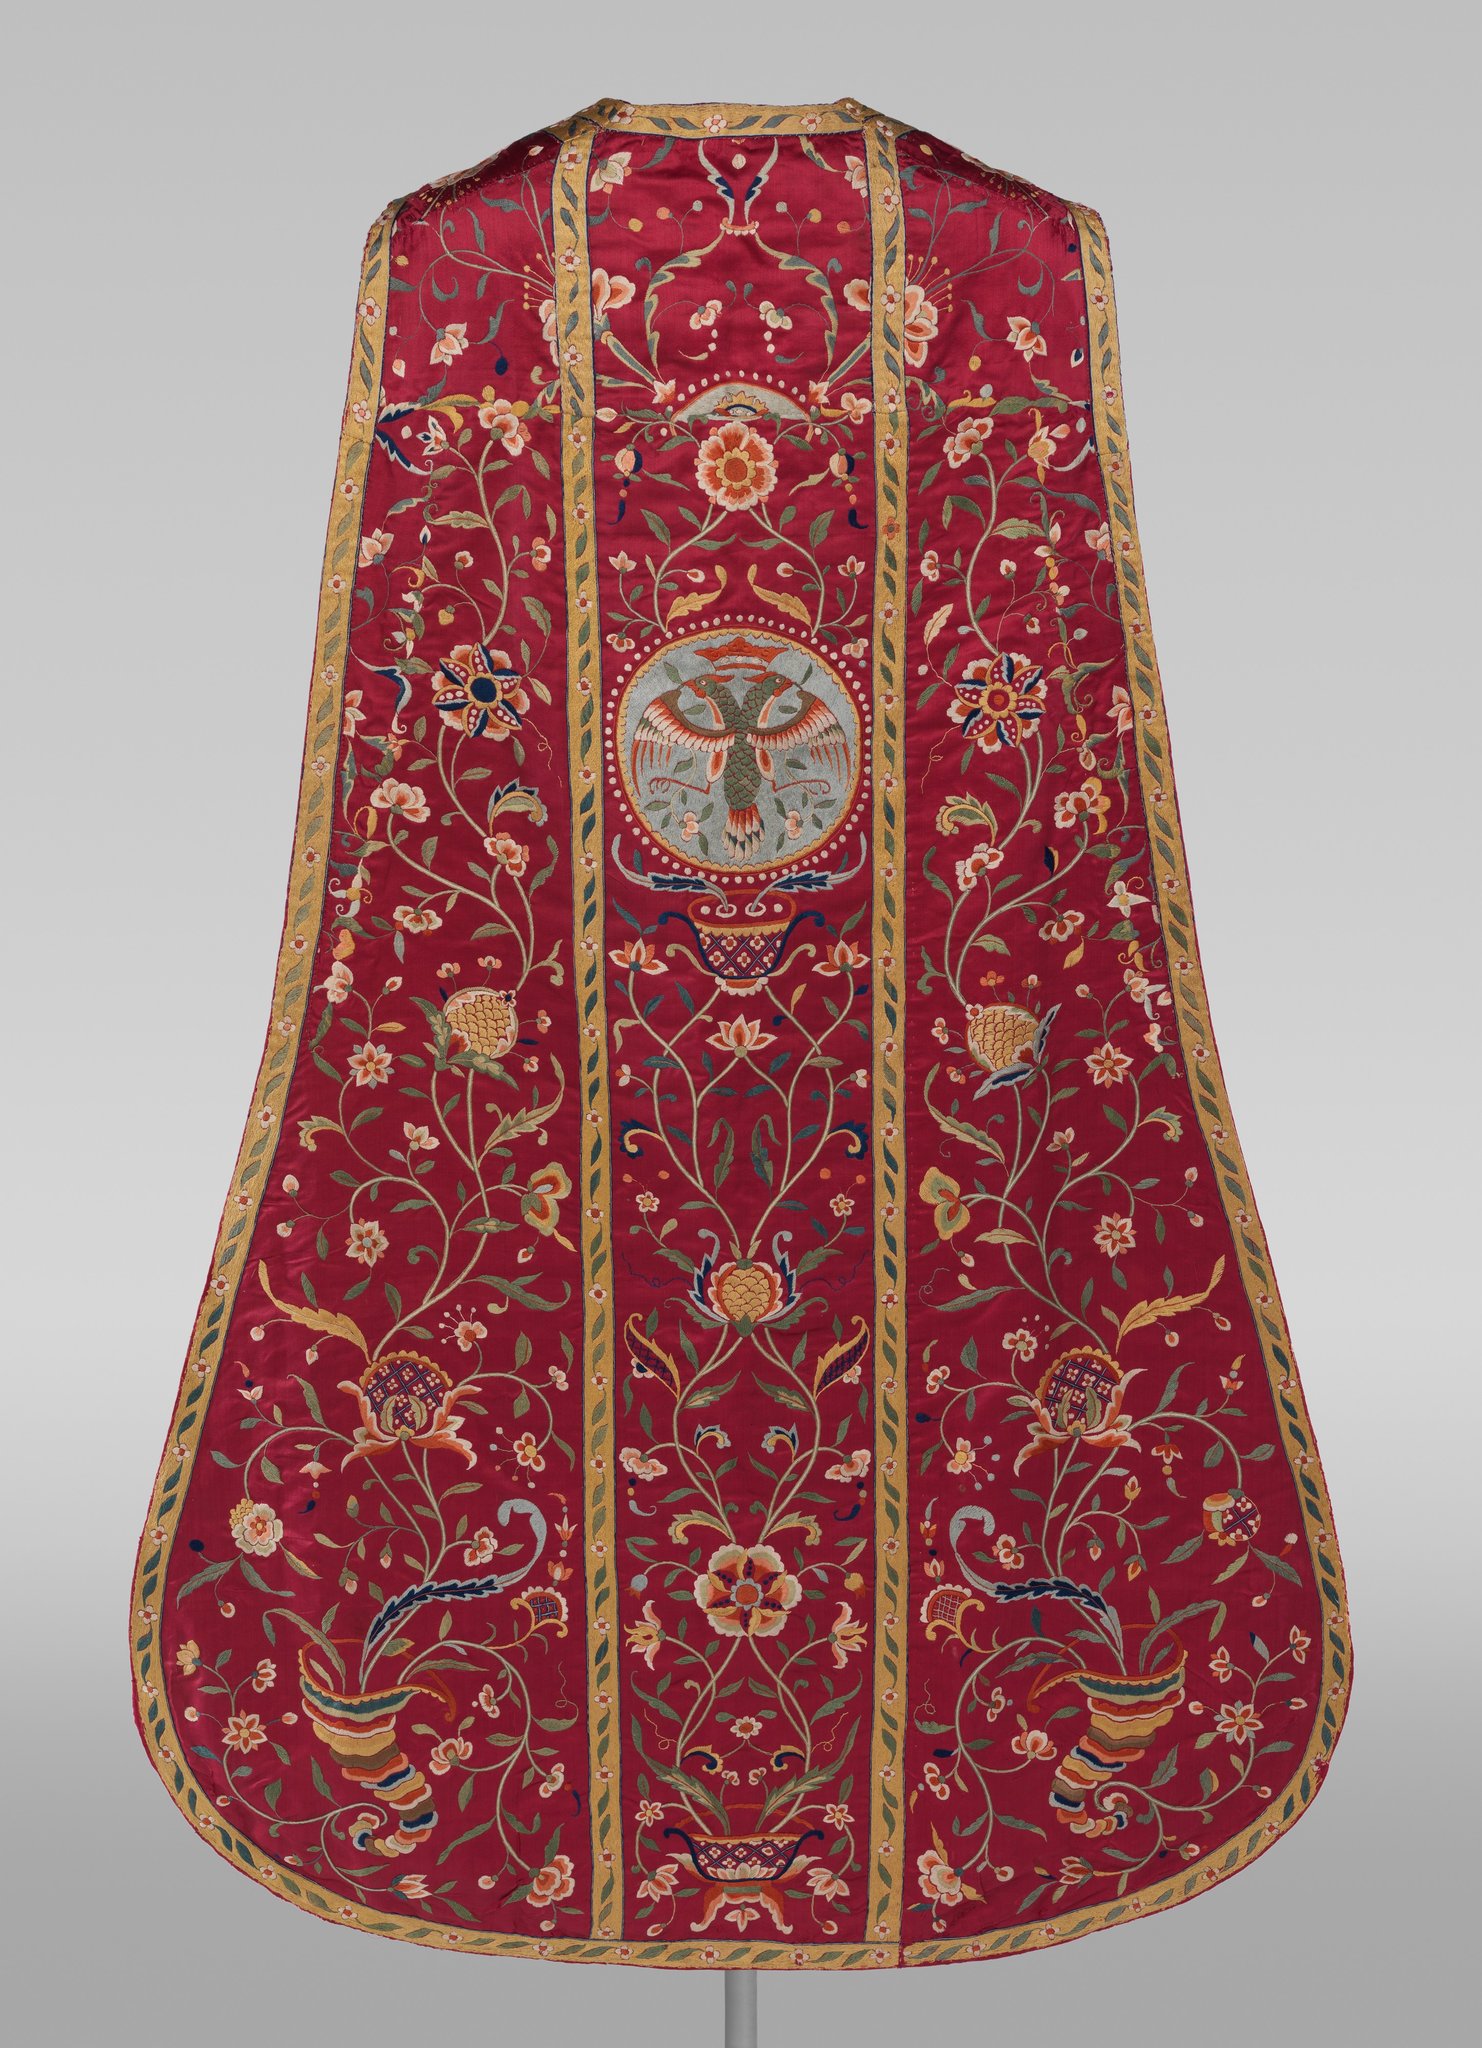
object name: chasuble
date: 1767-1800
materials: silk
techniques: embroidery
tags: flowers,leaves